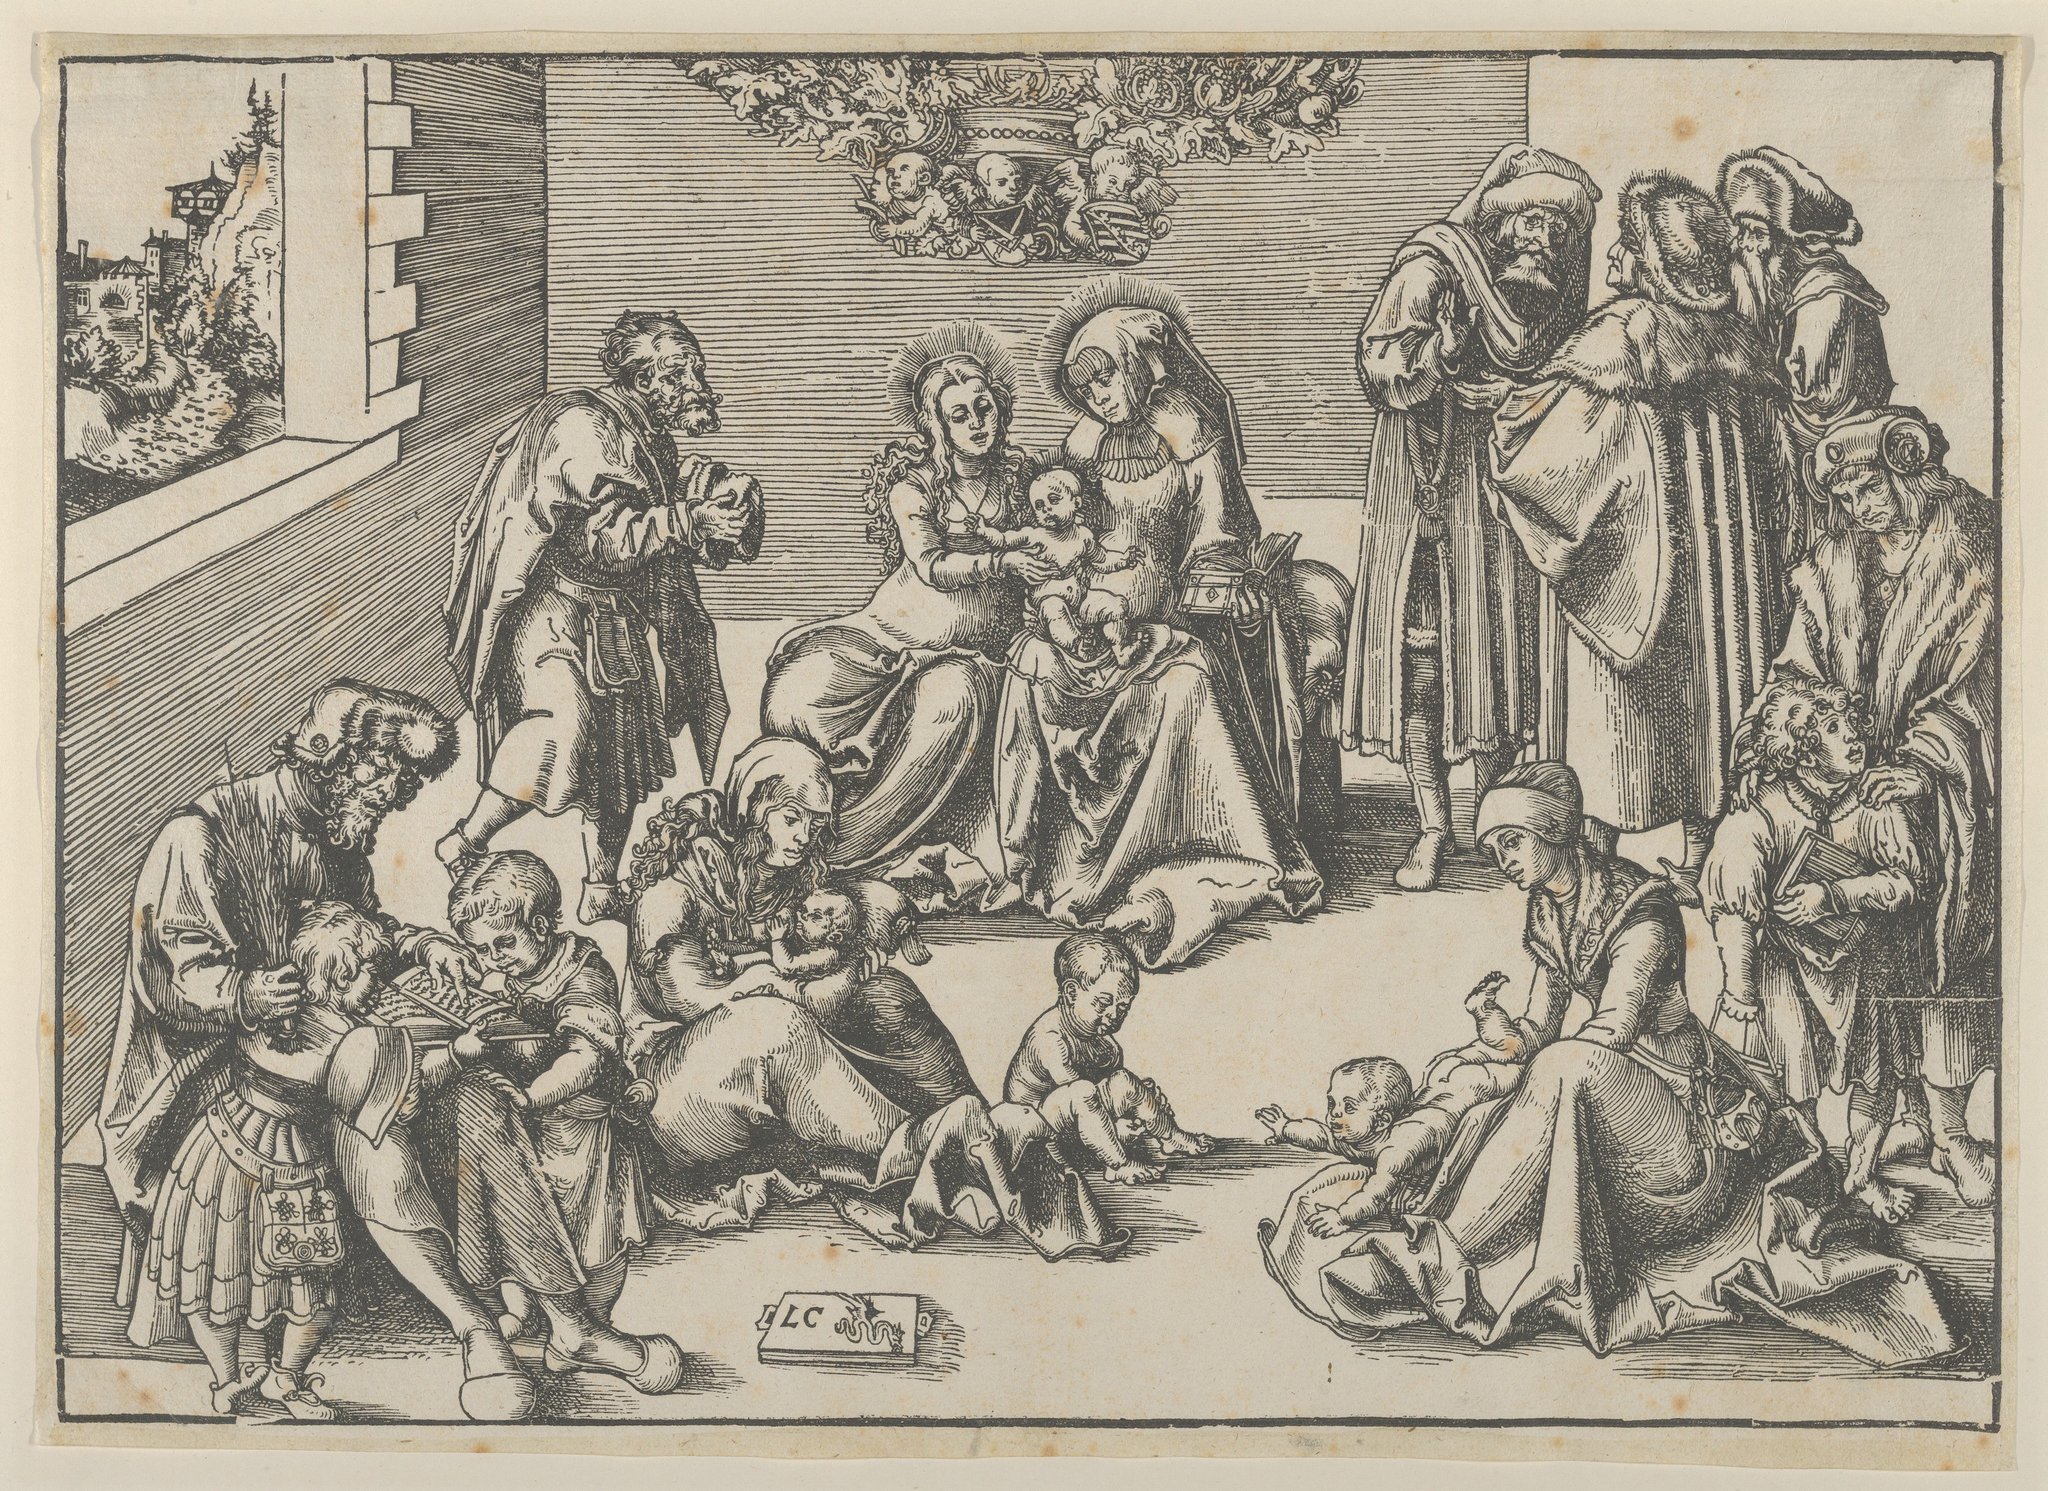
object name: print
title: The Holy Family and Kindred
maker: lucas cranach the elder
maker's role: artist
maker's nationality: german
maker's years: 1472-1553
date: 1472-1553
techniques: woodcut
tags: children,men,women,reading,holy family